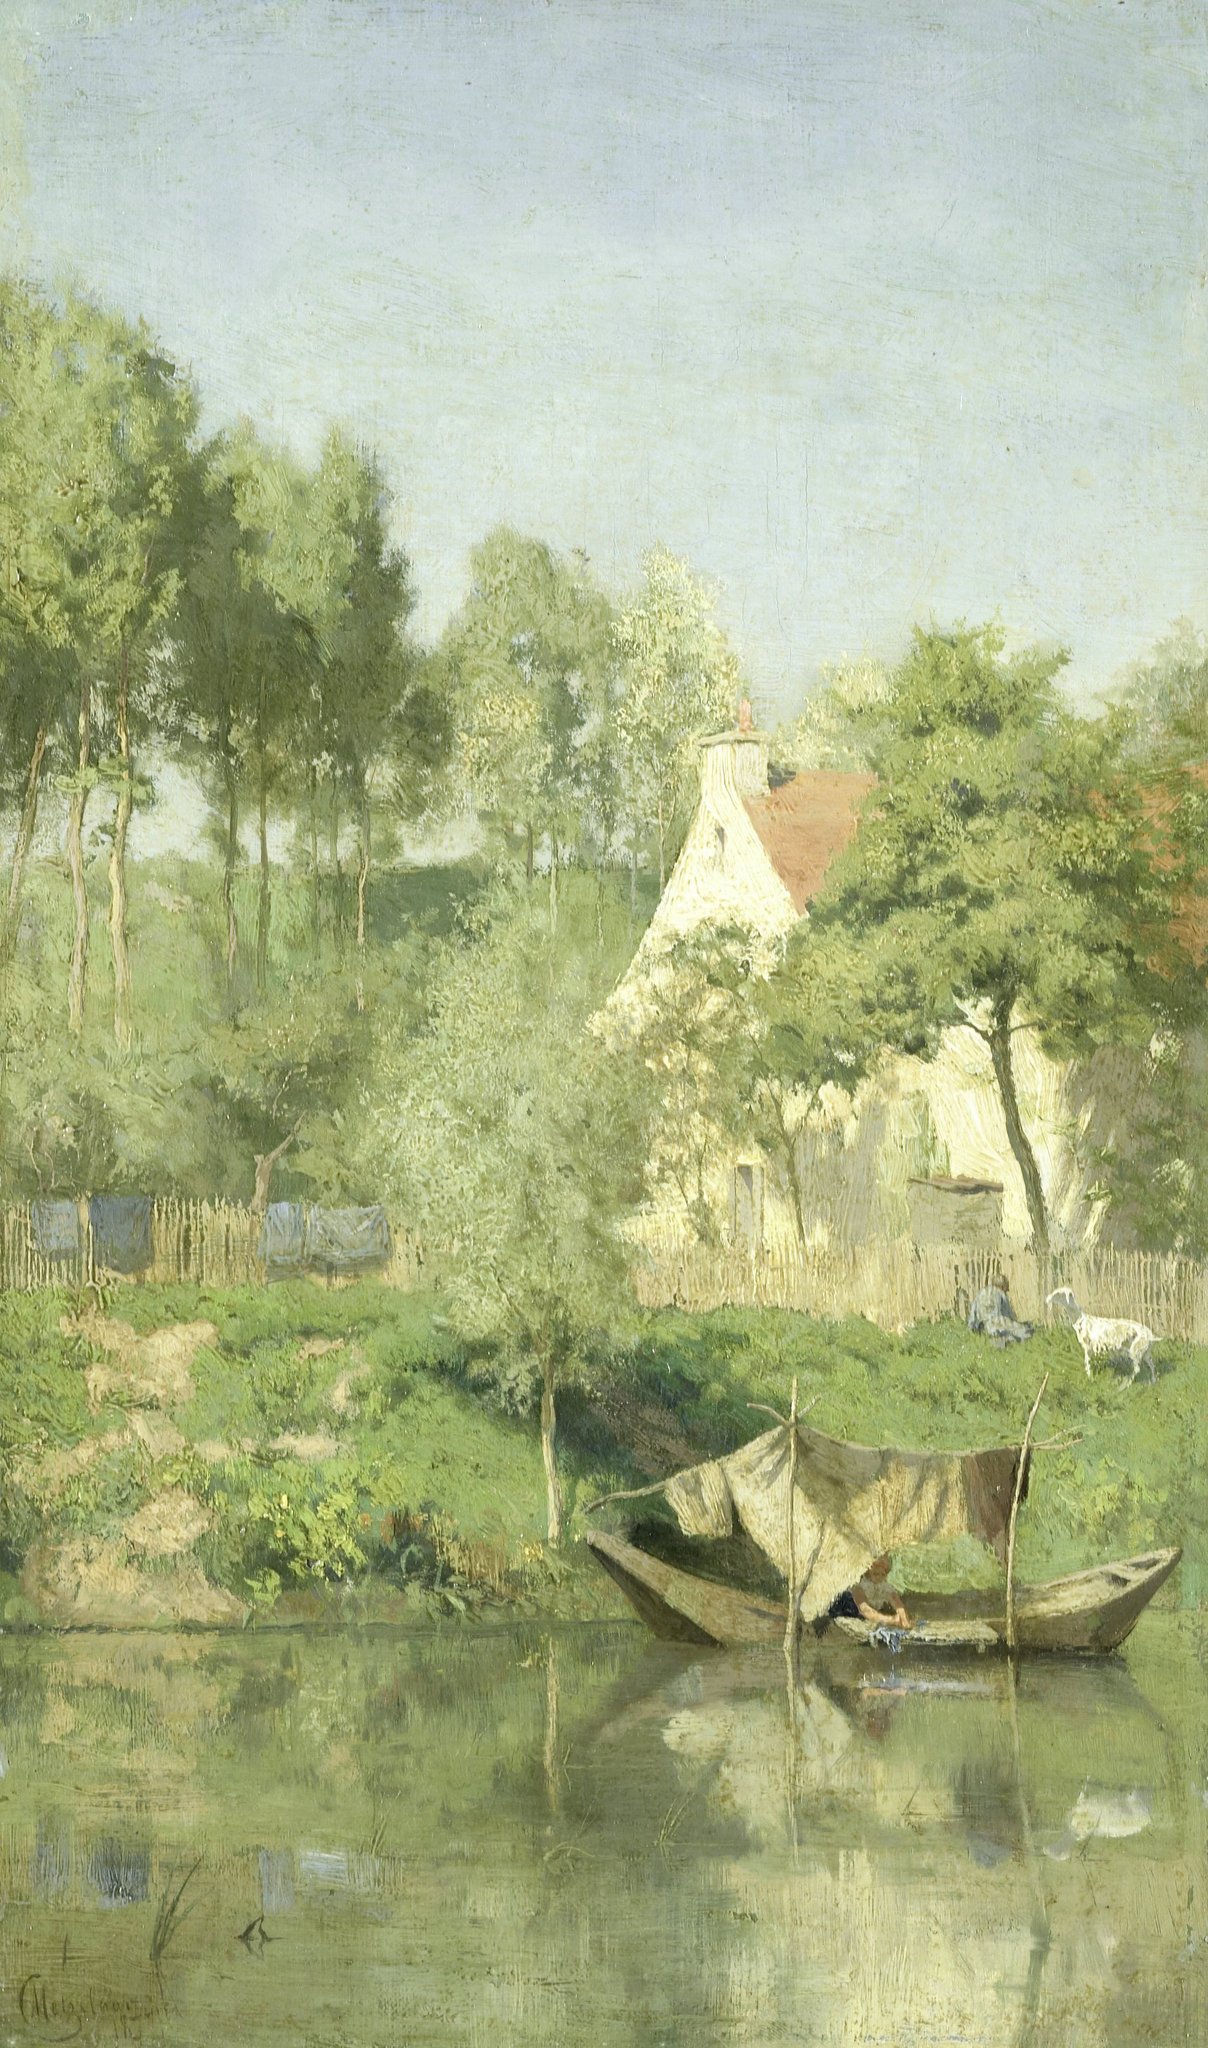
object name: painting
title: Aan de Oise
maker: coen metzelaar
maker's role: draughtsman, painter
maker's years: 1845-1881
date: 1877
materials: canvas, oil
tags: river (+ landscape with figures, staffage)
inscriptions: signature and date: ‘C. Metzelaar 1877’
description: Aan de Oise. Gezicht op een huis met tuin tussen bomen aan de oever van de rivier de Oise. Aan de wal ligt een bootje onder een afdakje van doeken. Op de oever een kind met een geit.